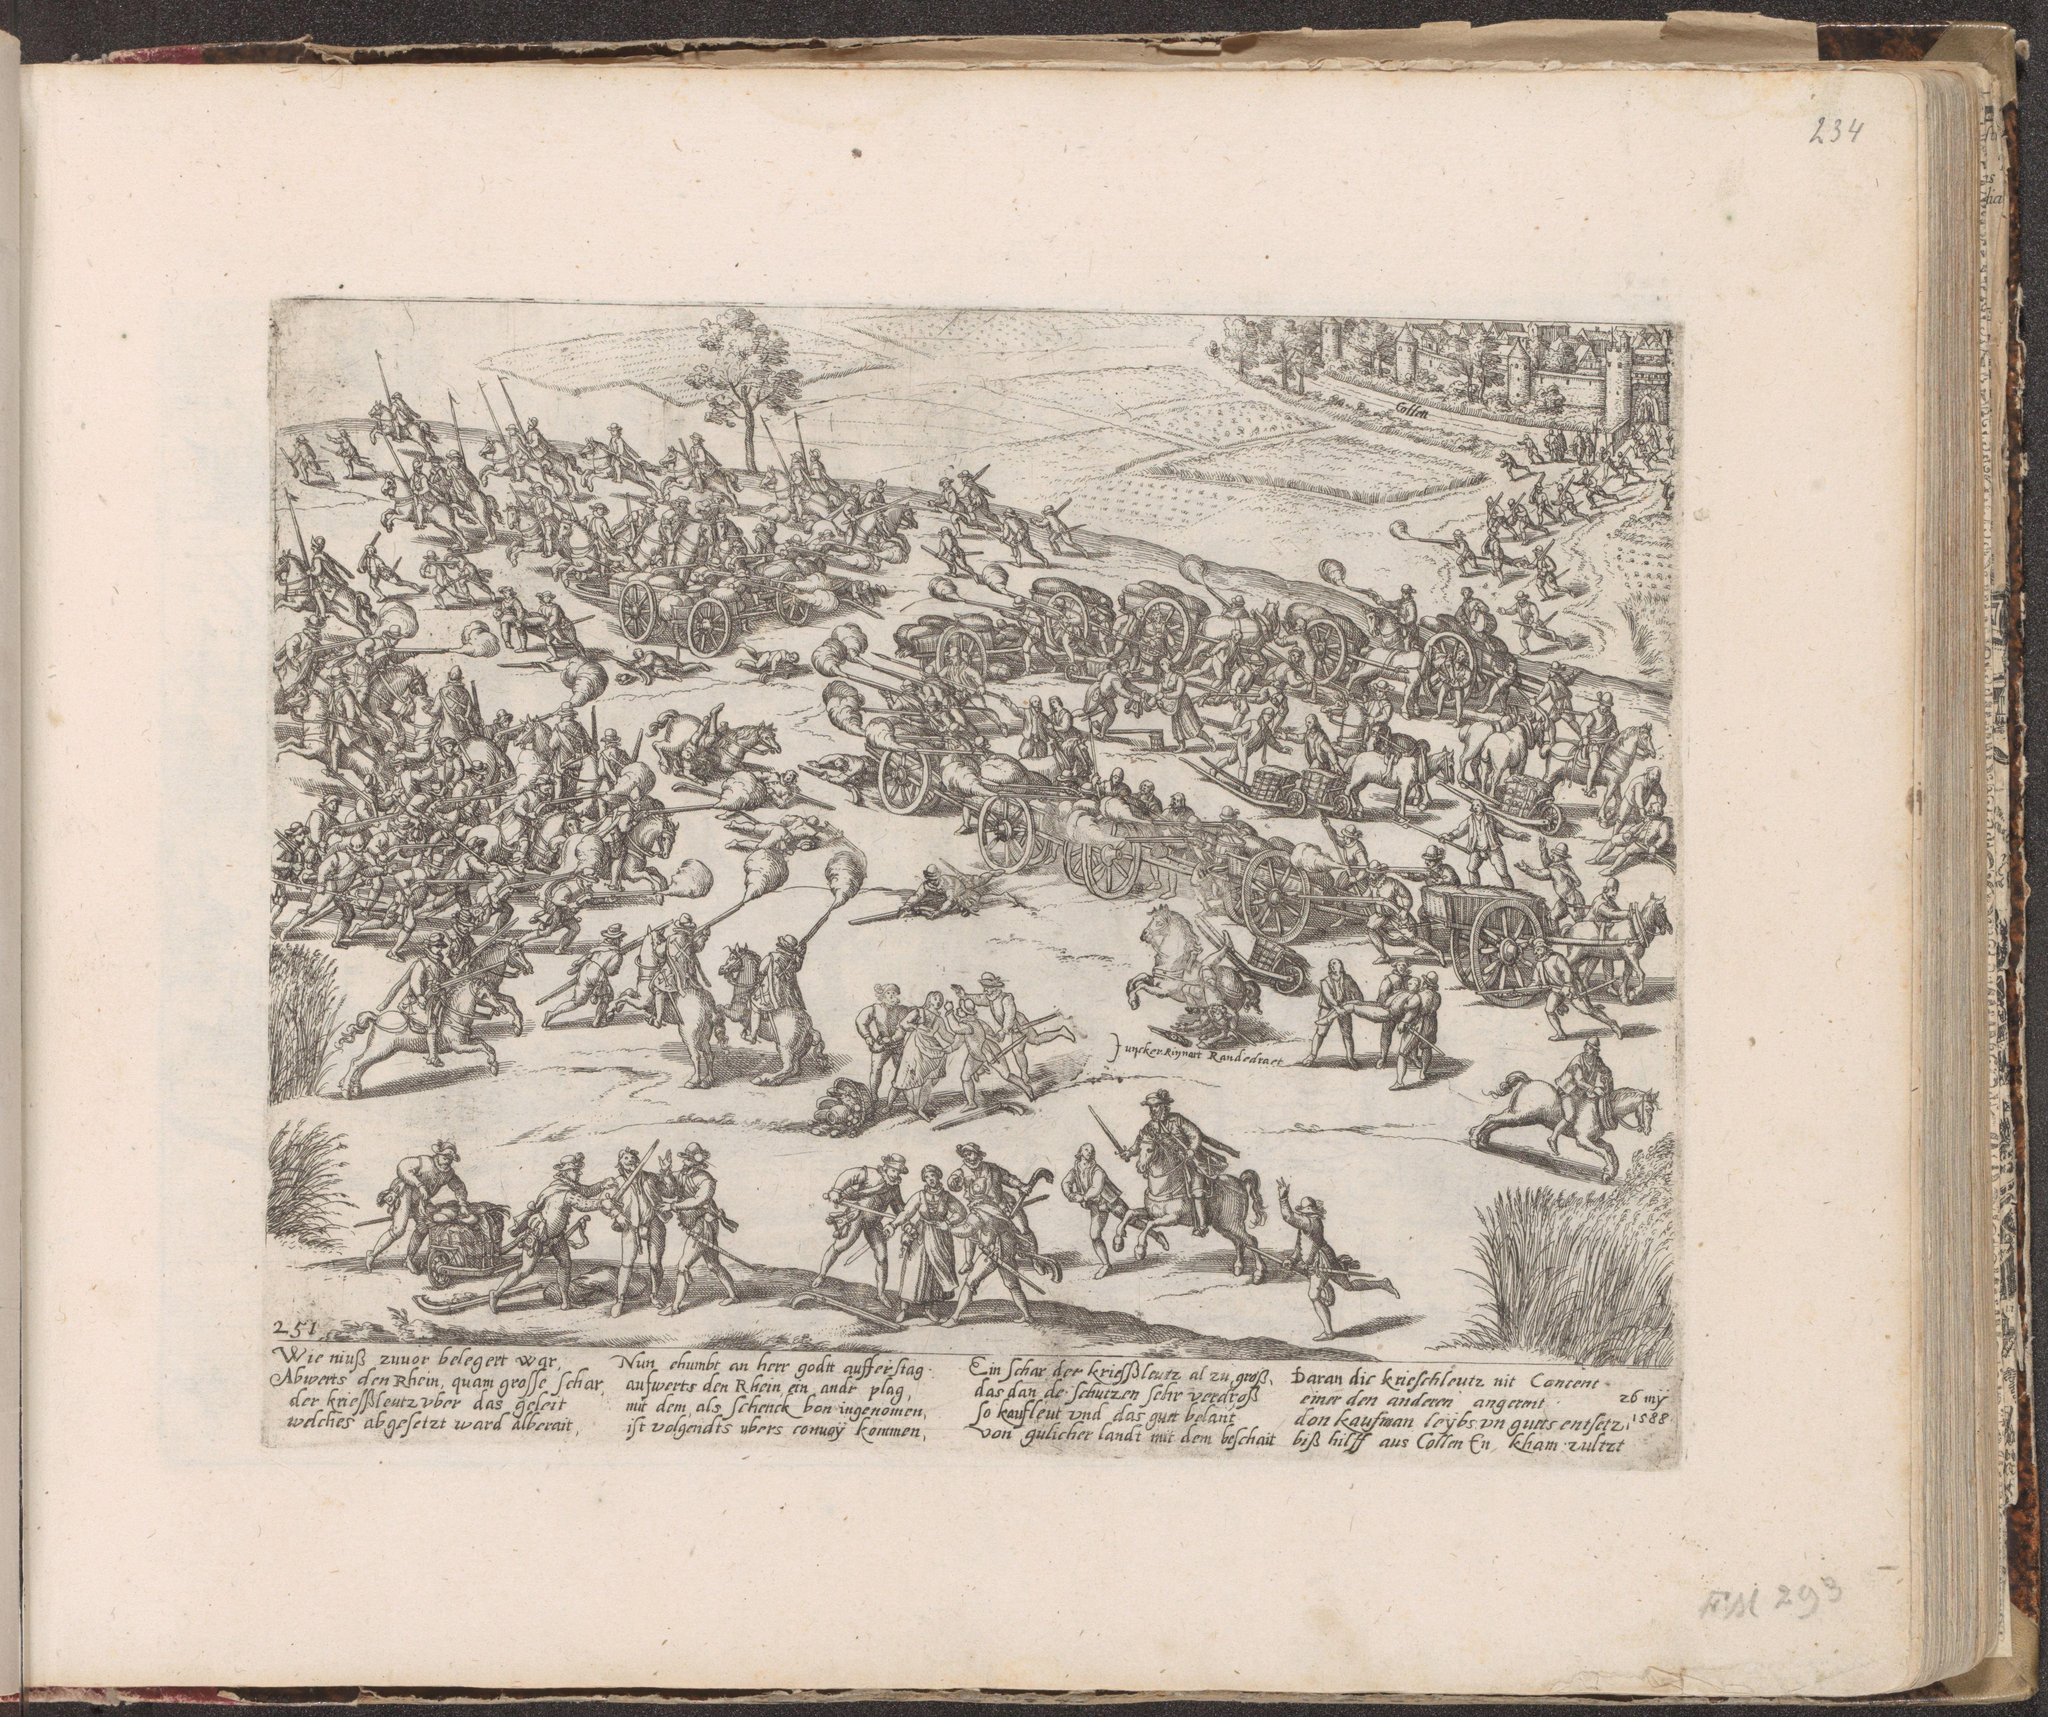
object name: album leaf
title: Gevechten buiten Keulen, 1588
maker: frans hogenberg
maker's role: print maker, publisher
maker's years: 1538-1590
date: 1588-1591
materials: paper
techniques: etching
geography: cologne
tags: cortege, funeral procession, cologne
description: Gevechten buiten Keulen, 26 mei 1588. Episode uit de Keulse Oorlog. Met onderschrift van 16 regels in het Duits. Linksonder genummerd: 251. De prent maakt deel uit van een album.